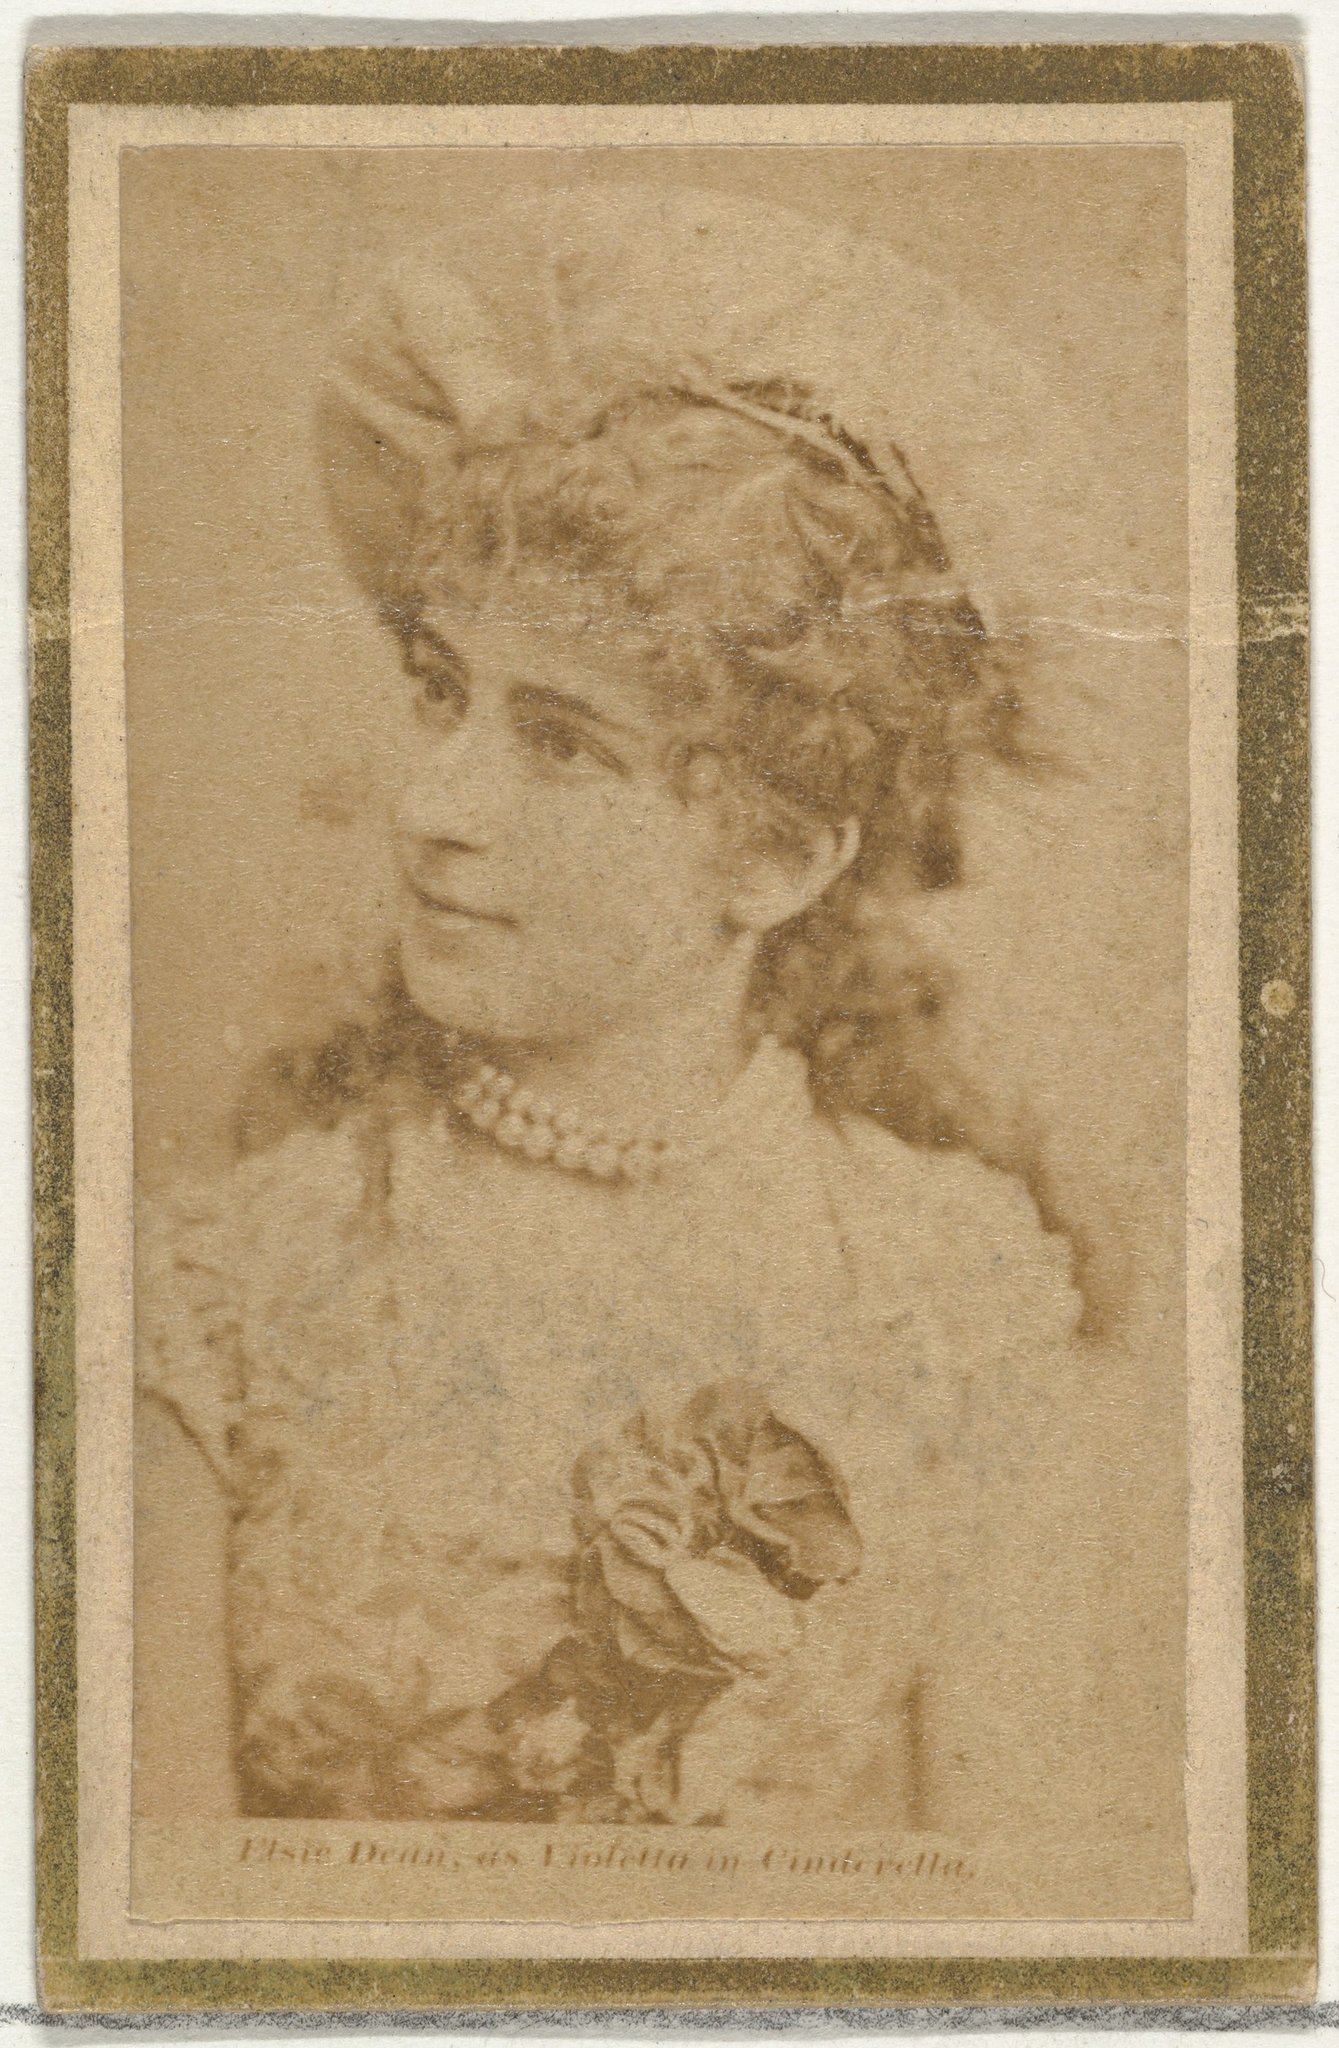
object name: photograph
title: Elsie Dean as Violetta in Cinderella, from the Actresses and Celebrities series (N60, Type 2) promoting Little Beauties Cigarettes for Allen & Ginter brand tobacco products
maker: allen & ginter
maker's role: publisher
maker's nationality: american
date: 1887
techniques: albumen silver print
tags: portraits,women,actresses